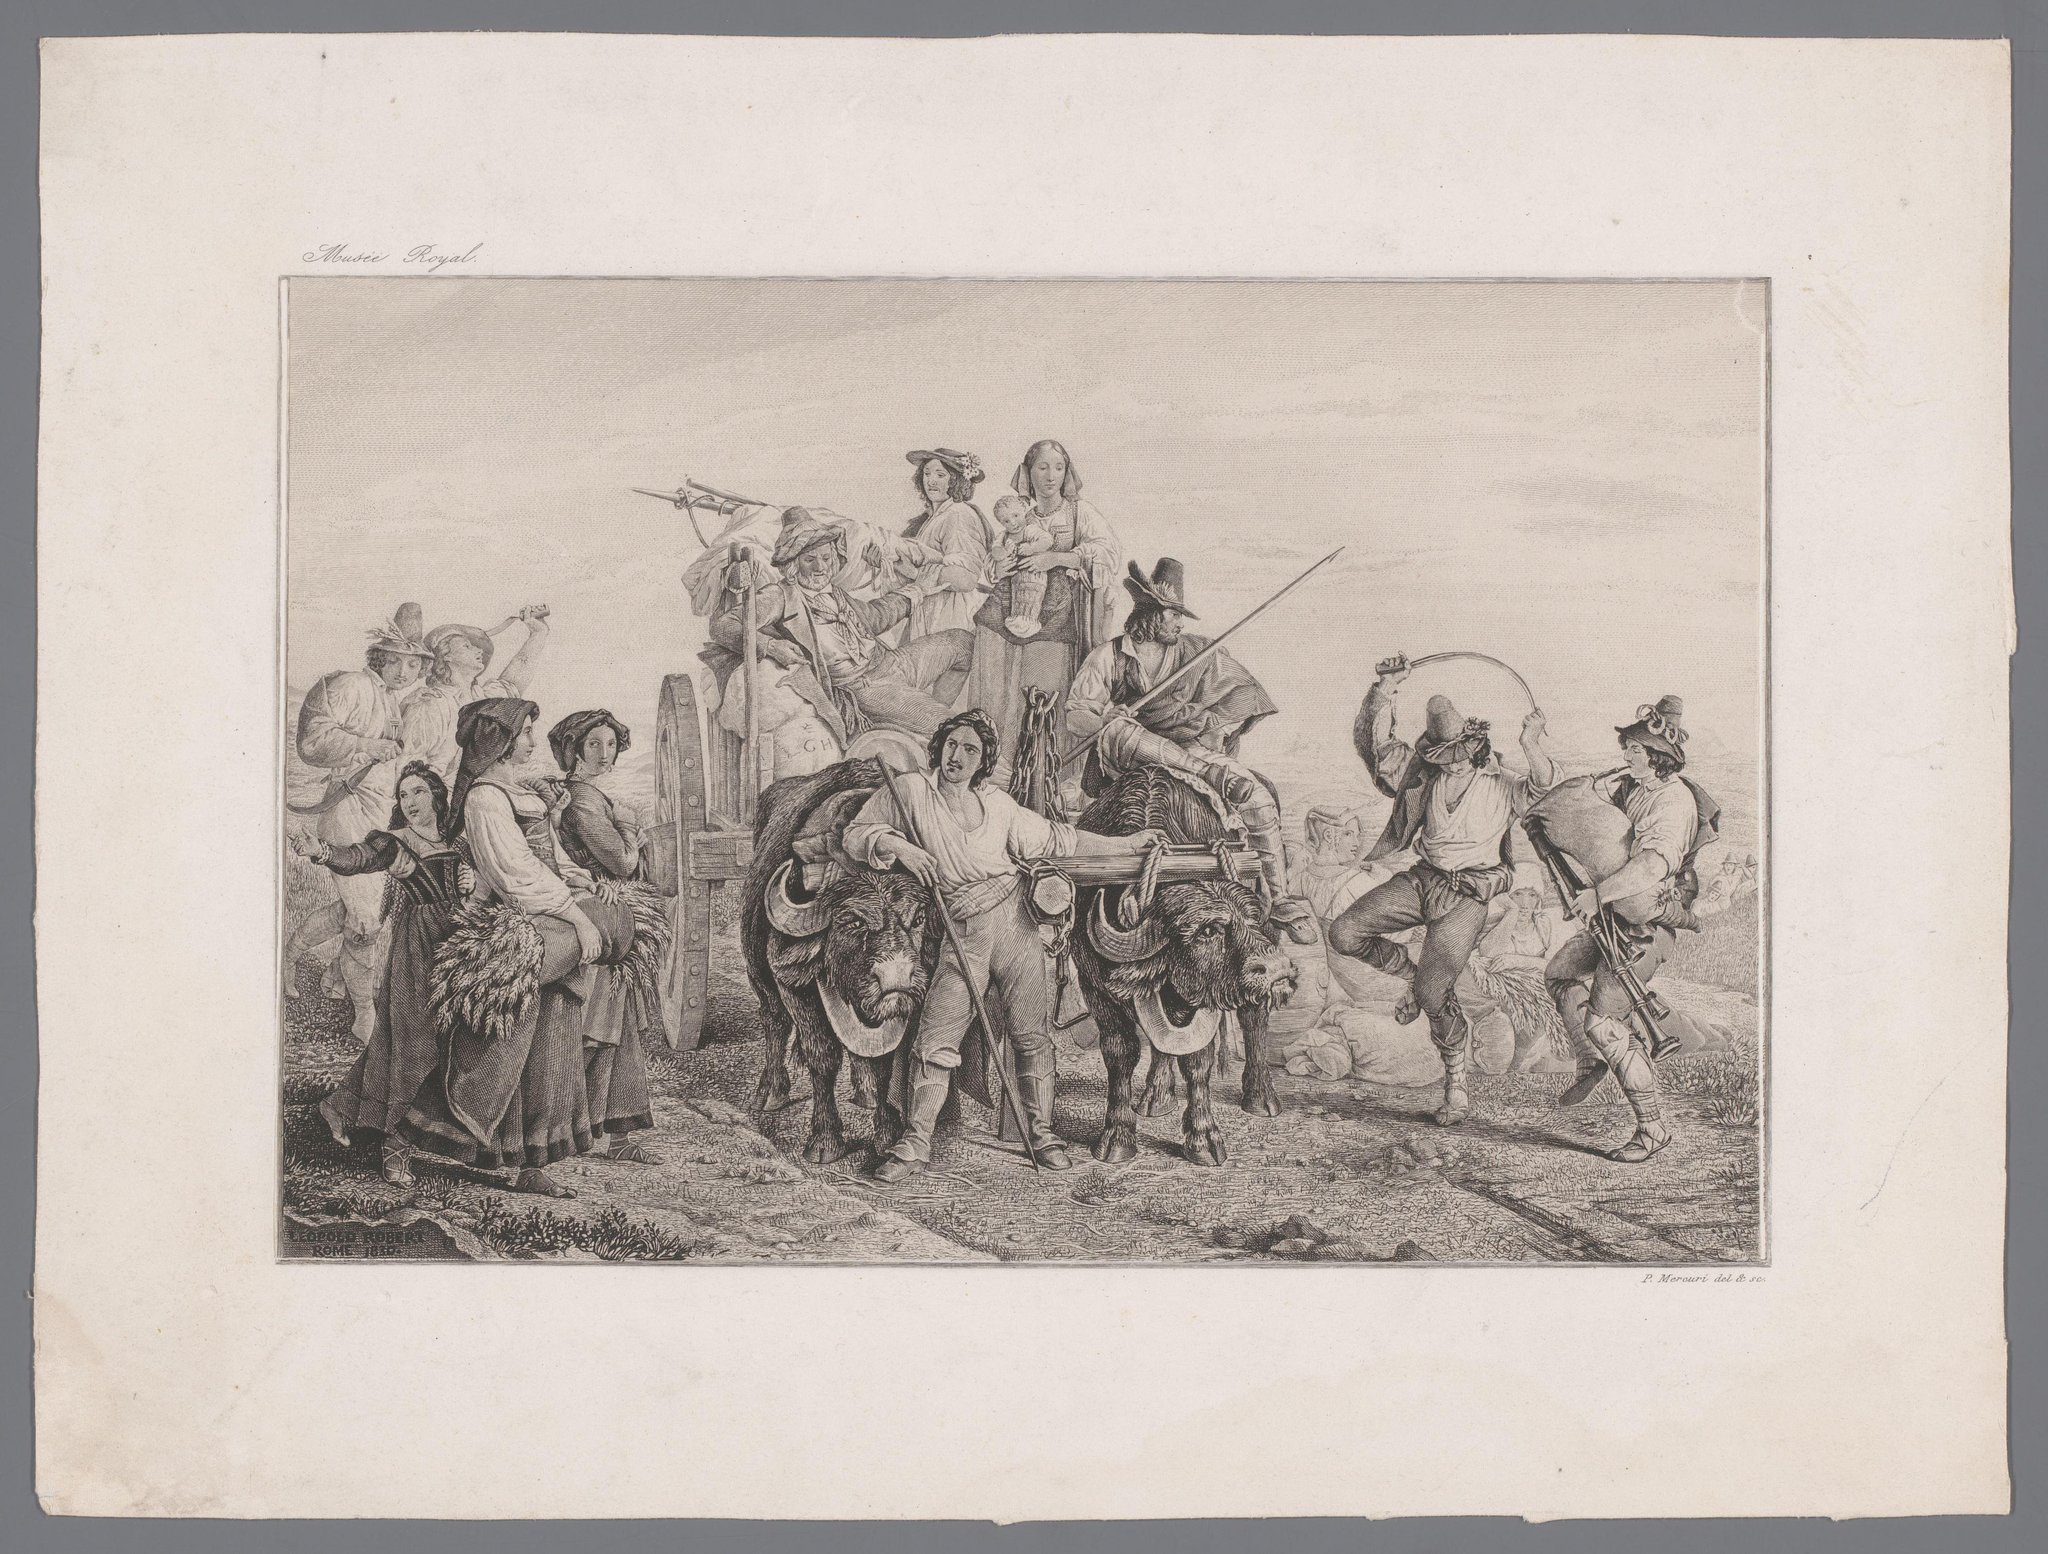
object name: print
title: Oogstfeest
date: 1831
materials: paper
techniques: engraving, etching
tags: harvest, harvest festivities